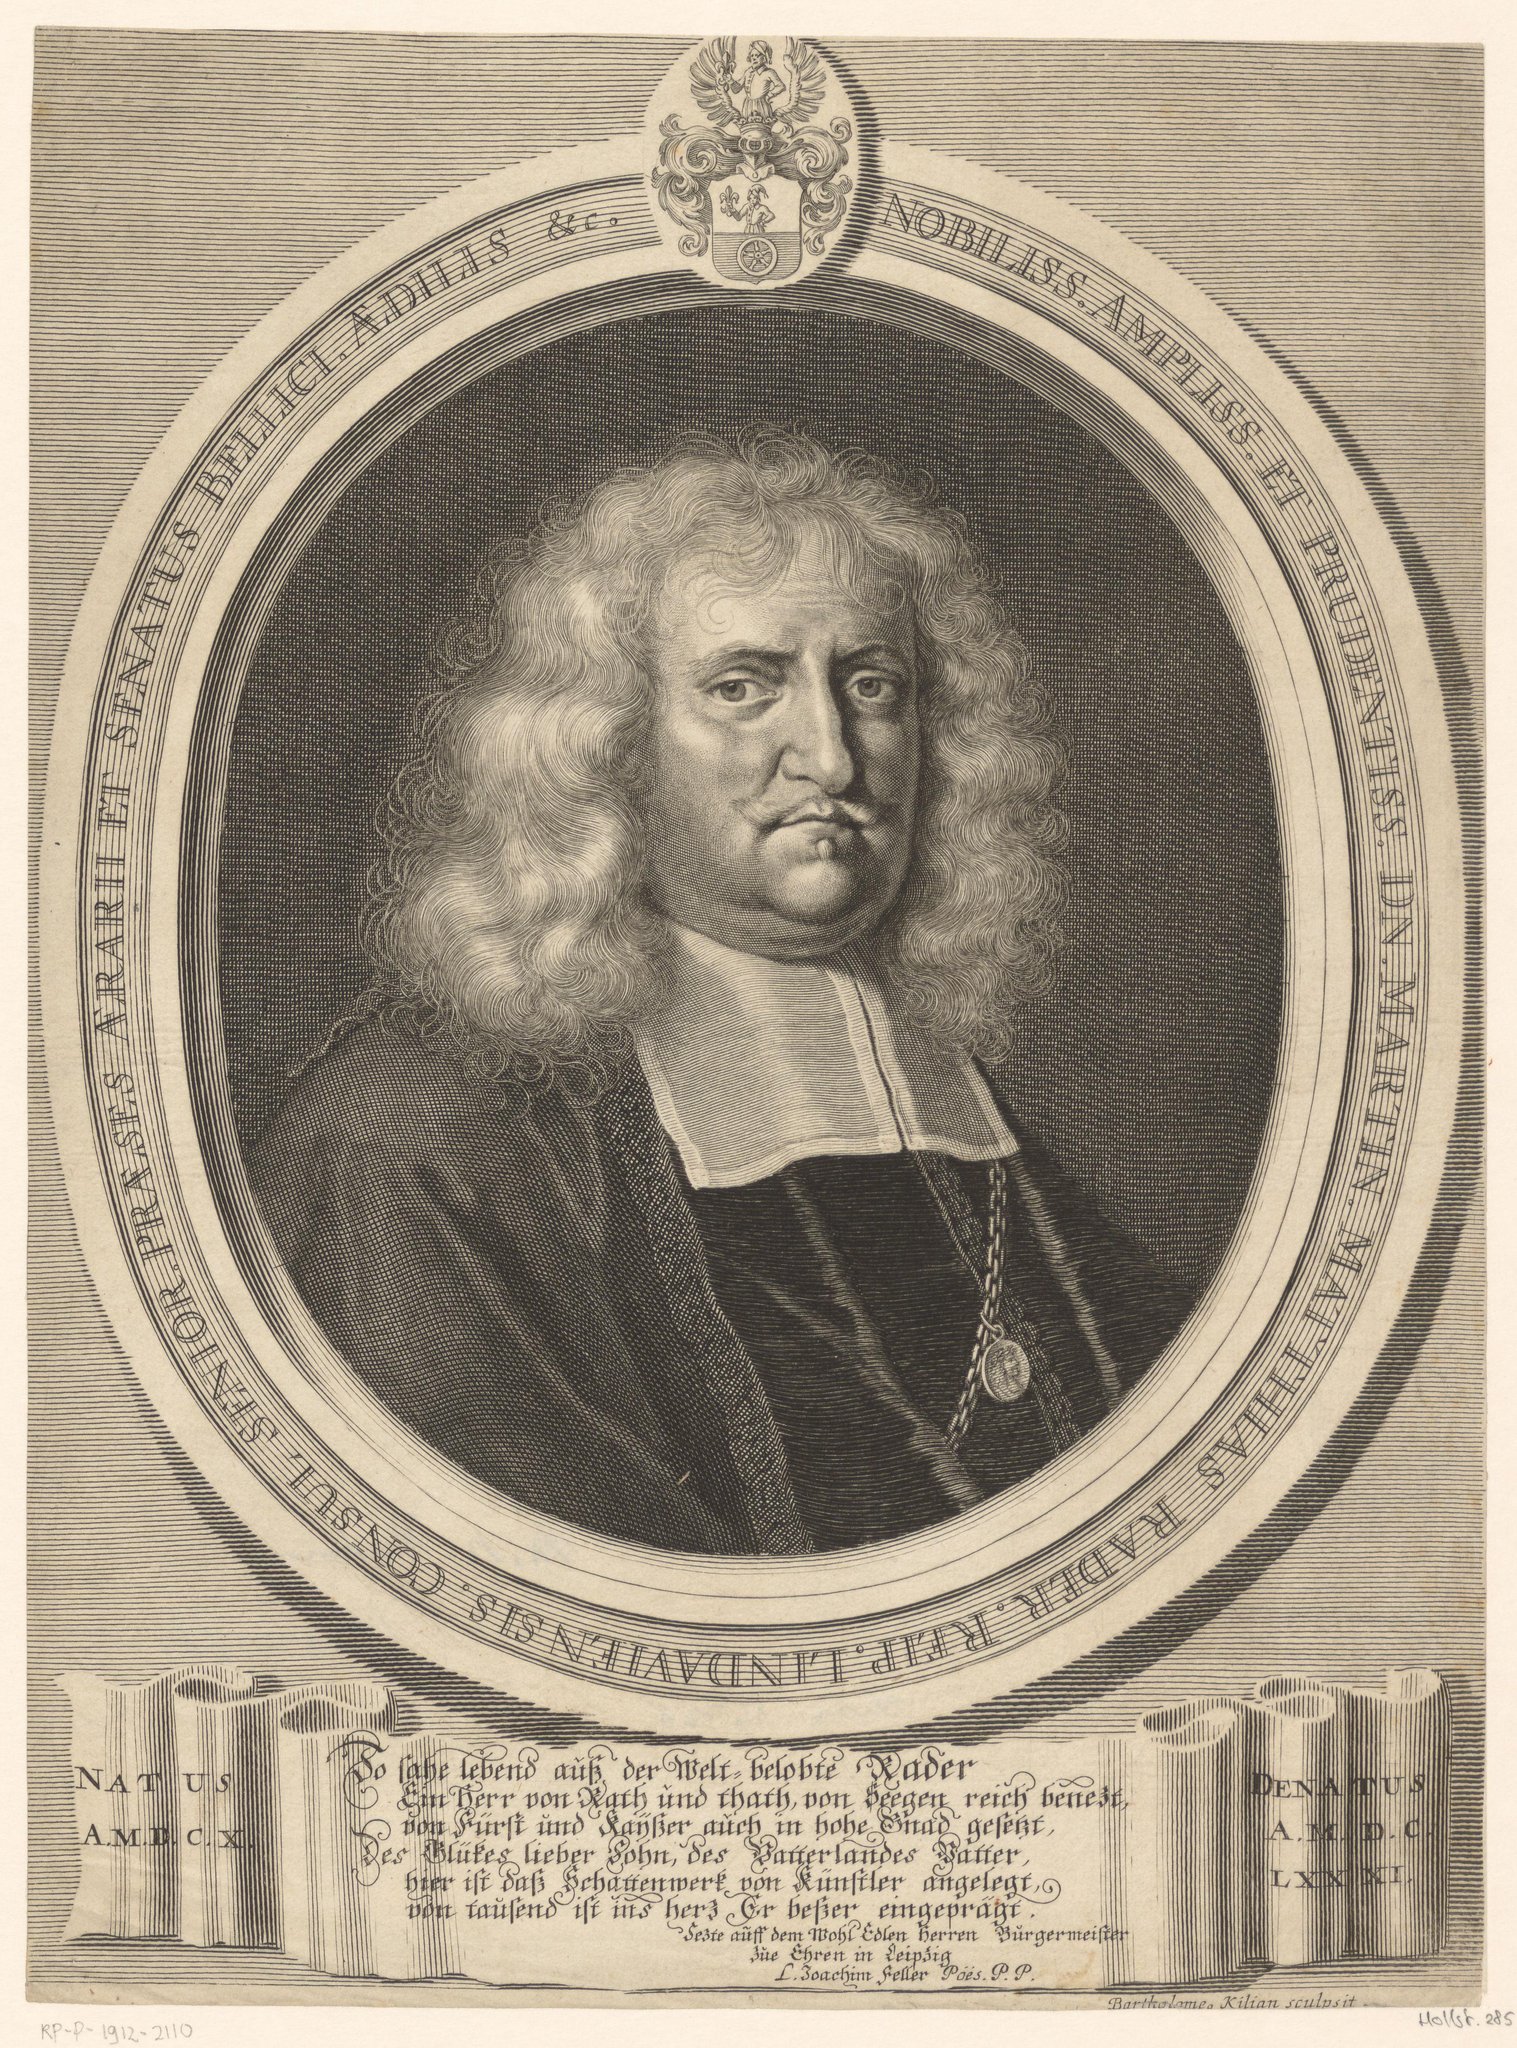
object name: print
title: Portret van Martin Matthias Rader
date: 1681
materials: paper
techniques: engraving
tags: mayor, mayor, burgomaster, historical persons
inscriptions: collector's mark: Lugt 2228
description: Tekst in het Latijn in de omlijsting en Duits in de marge.